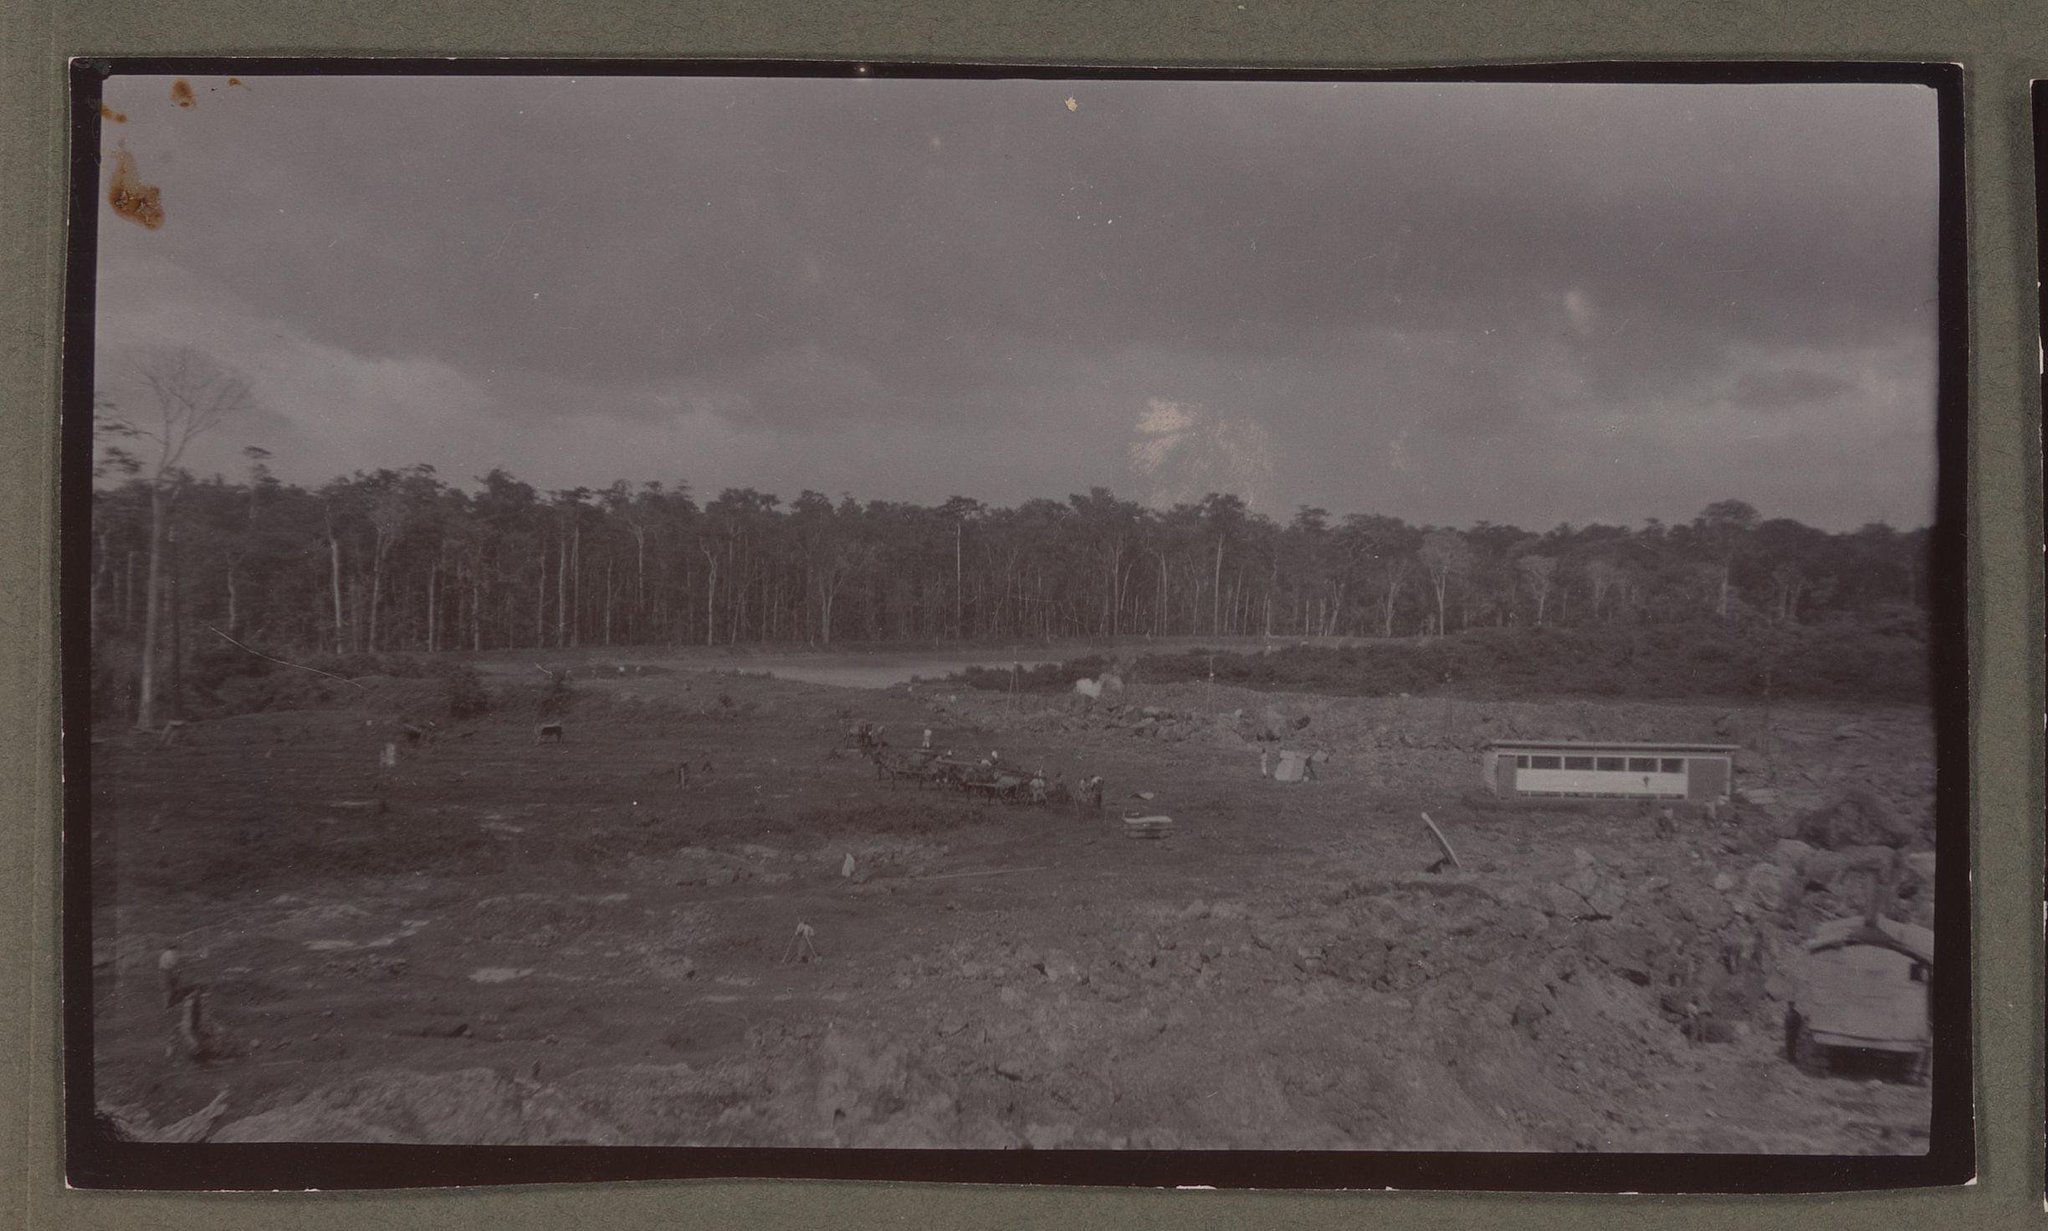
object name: photograph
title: Mijn en fabriek in Moengo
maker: Anonymous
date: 1925-1927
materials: photographic support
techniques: photography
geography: suriname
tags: jetten, familie, moengo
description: Terrein van de mijn en fabriek in Moengo. Foto op een bladzijde van een los albumblad. Onderdeel van het ensemble met foto's van de familie van ingenieur Jetten in de mijnbouwstad Moengo in Suriname.